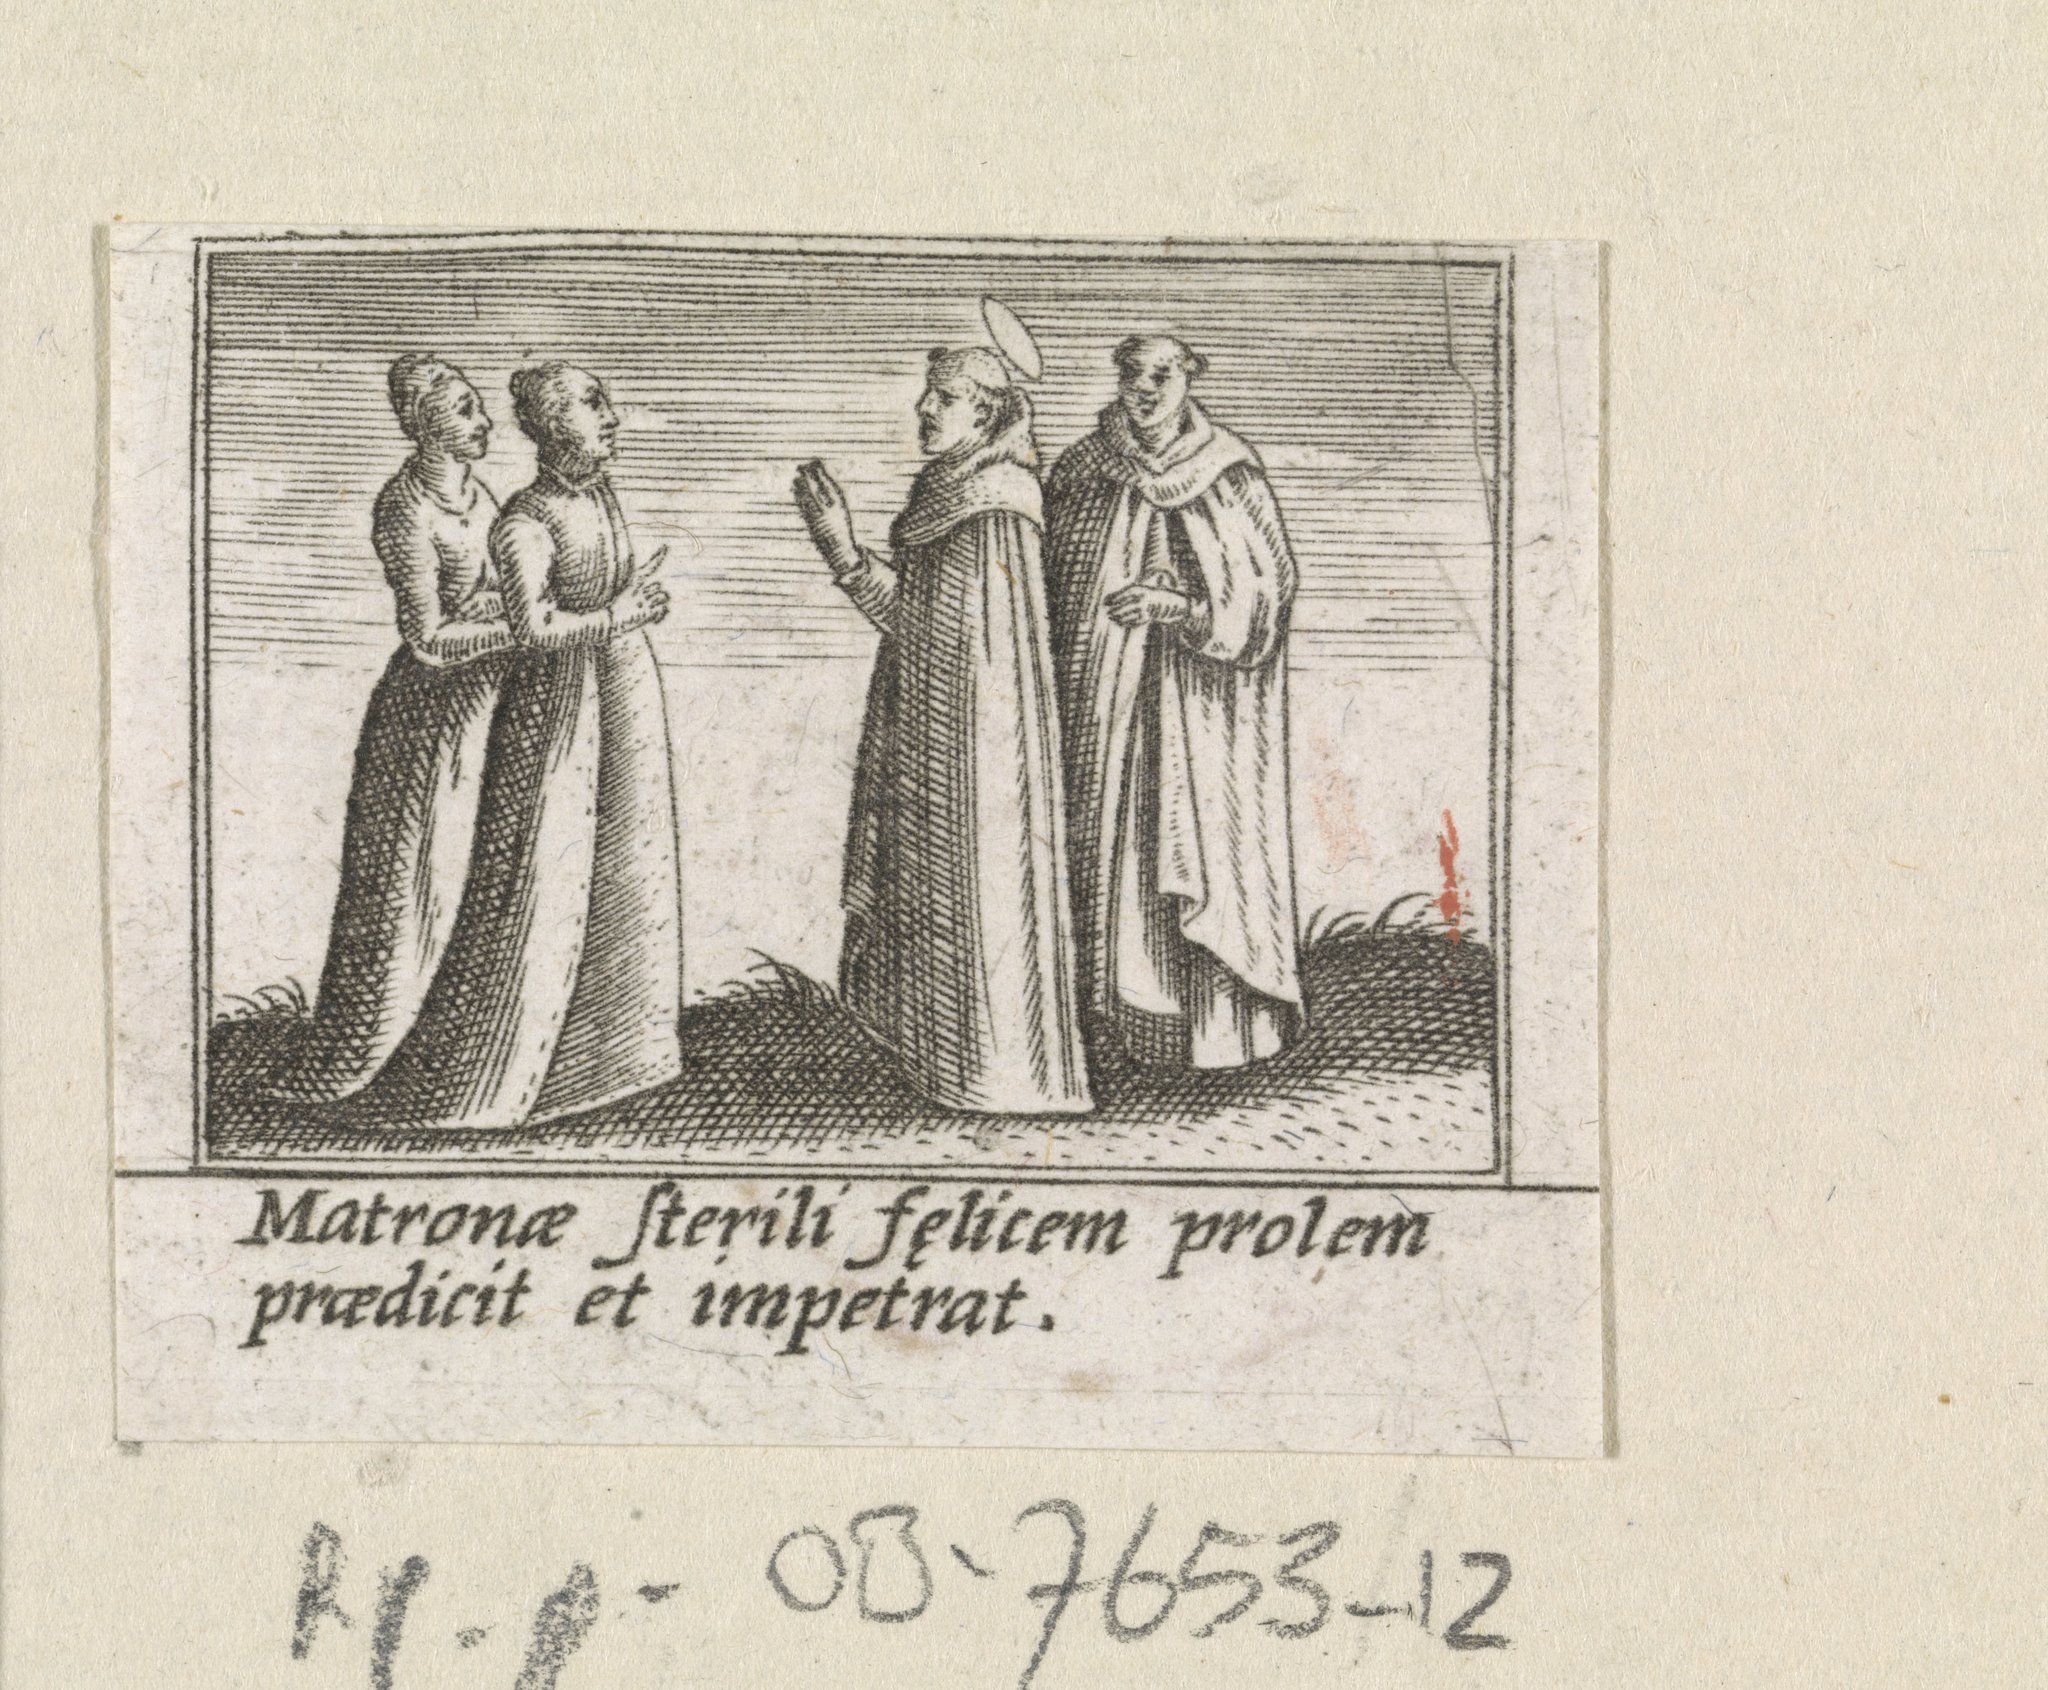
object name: print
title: Miraculeuze genezing van twee onvruchtbare vrouwen door de Heilige Hyacinthus van Polen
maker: johann sadeler (i)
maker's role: print maker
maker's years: 1550-1600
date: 1595-1600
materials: paper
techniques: engraving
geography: venice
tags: miraculous healings of st. hyacinth of poland, sterility; barren woman, monk(s), friar(s)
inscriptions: collector's mark: Lugt 240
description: Twee onvruchtbare vrouwen worden door de H. Hyacinthus van Polen en een monnik begroet. De heilige geneest hen van hun onvruchtbaarheid. De prent maakt deel uit van een achttiendelige serie die een kader vormt rondom een afbeelding van de H. Hyacinthus van Polen.